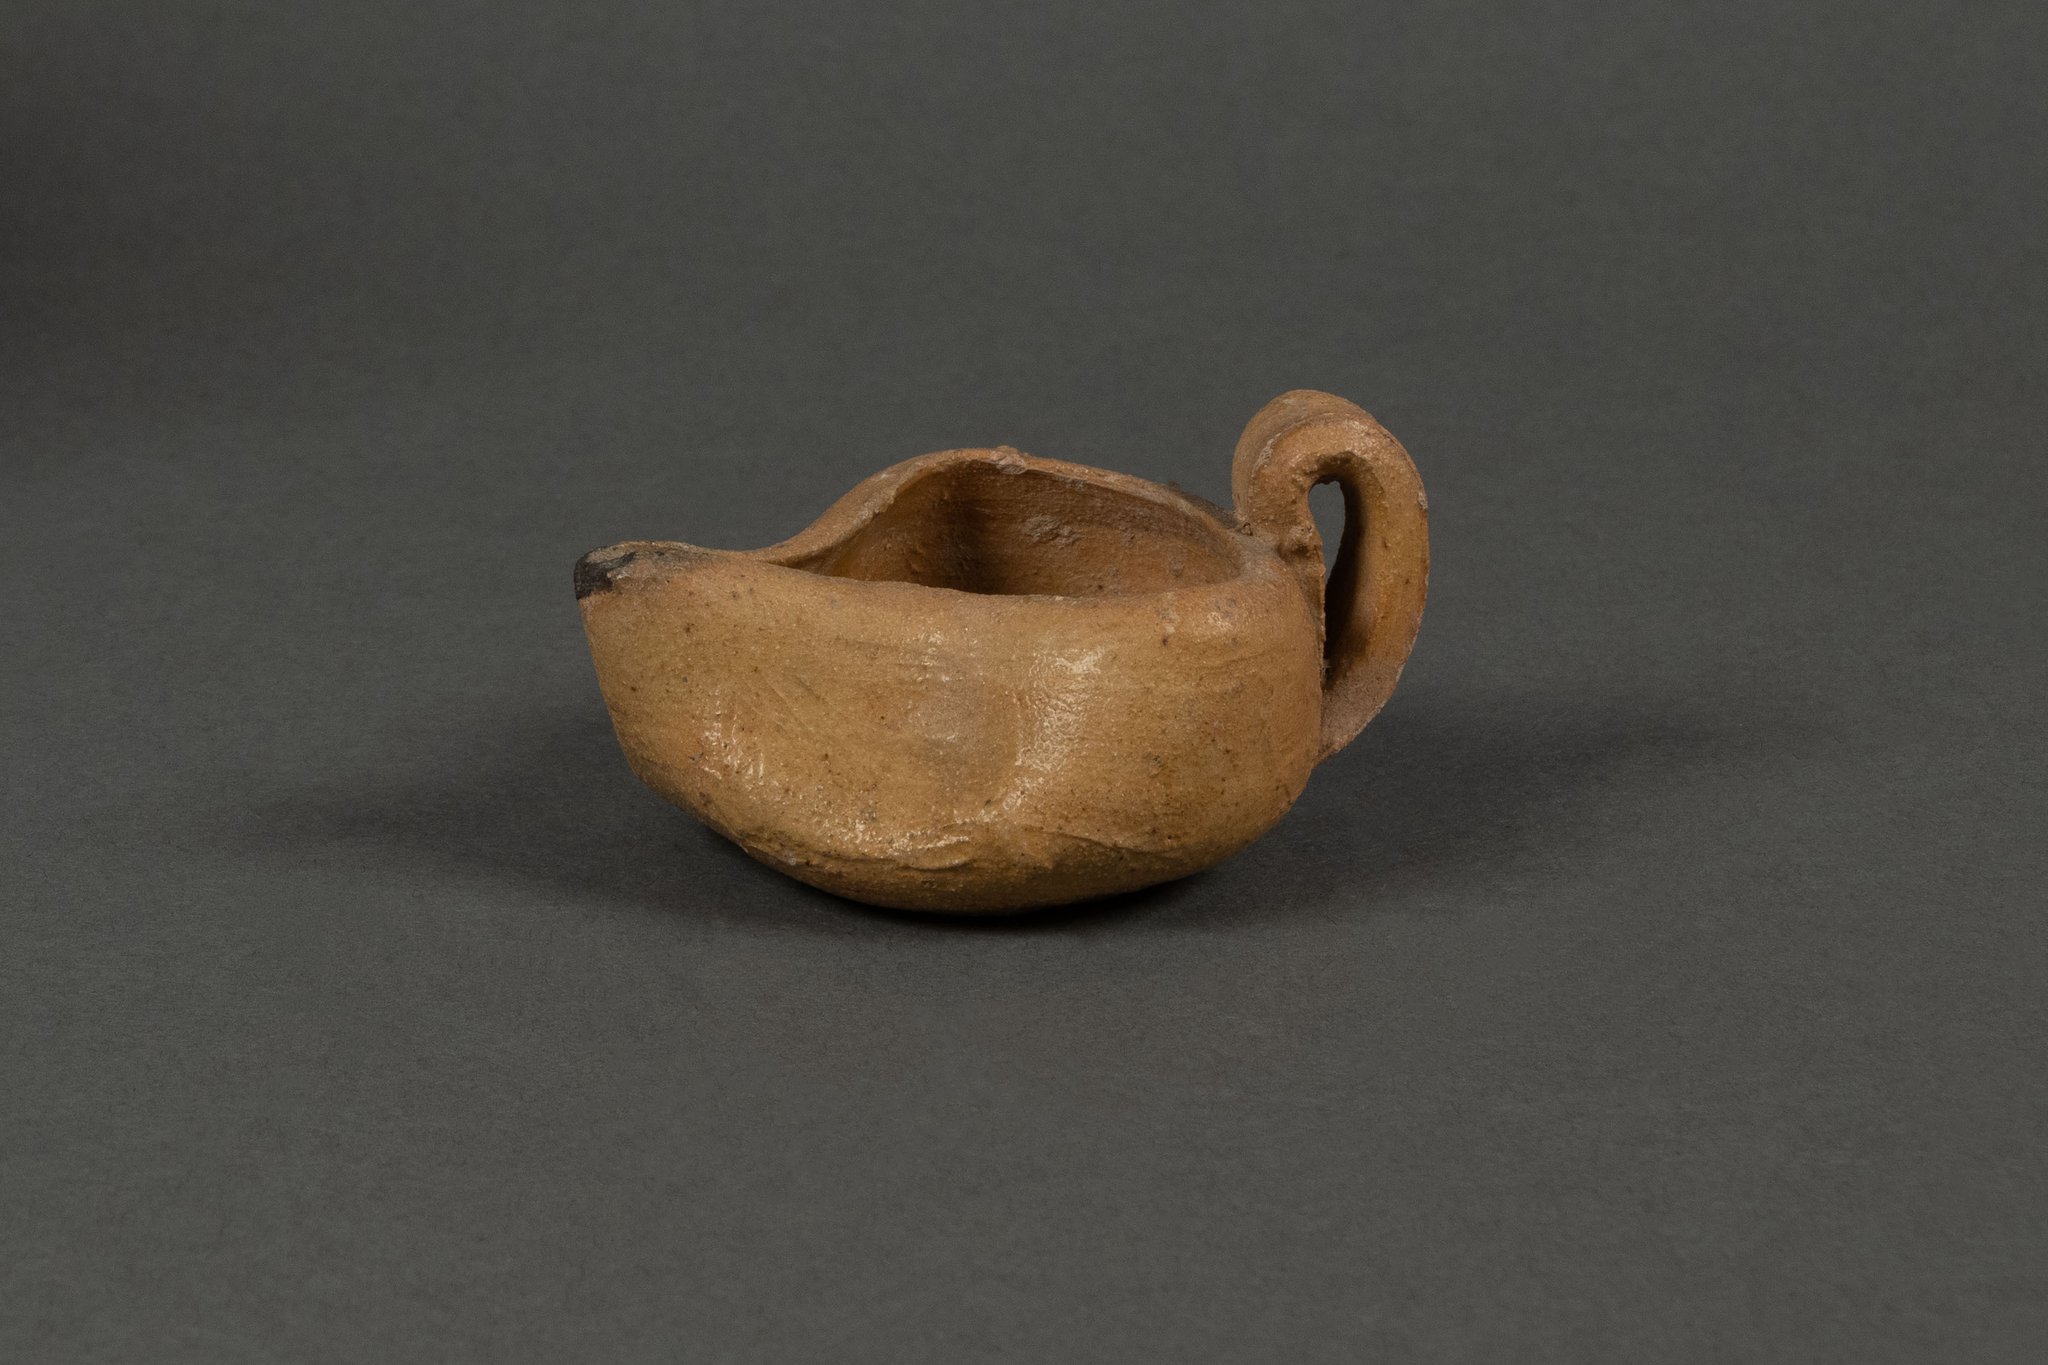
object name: lamp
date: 801-1000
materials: earthenware, glaze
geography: iran